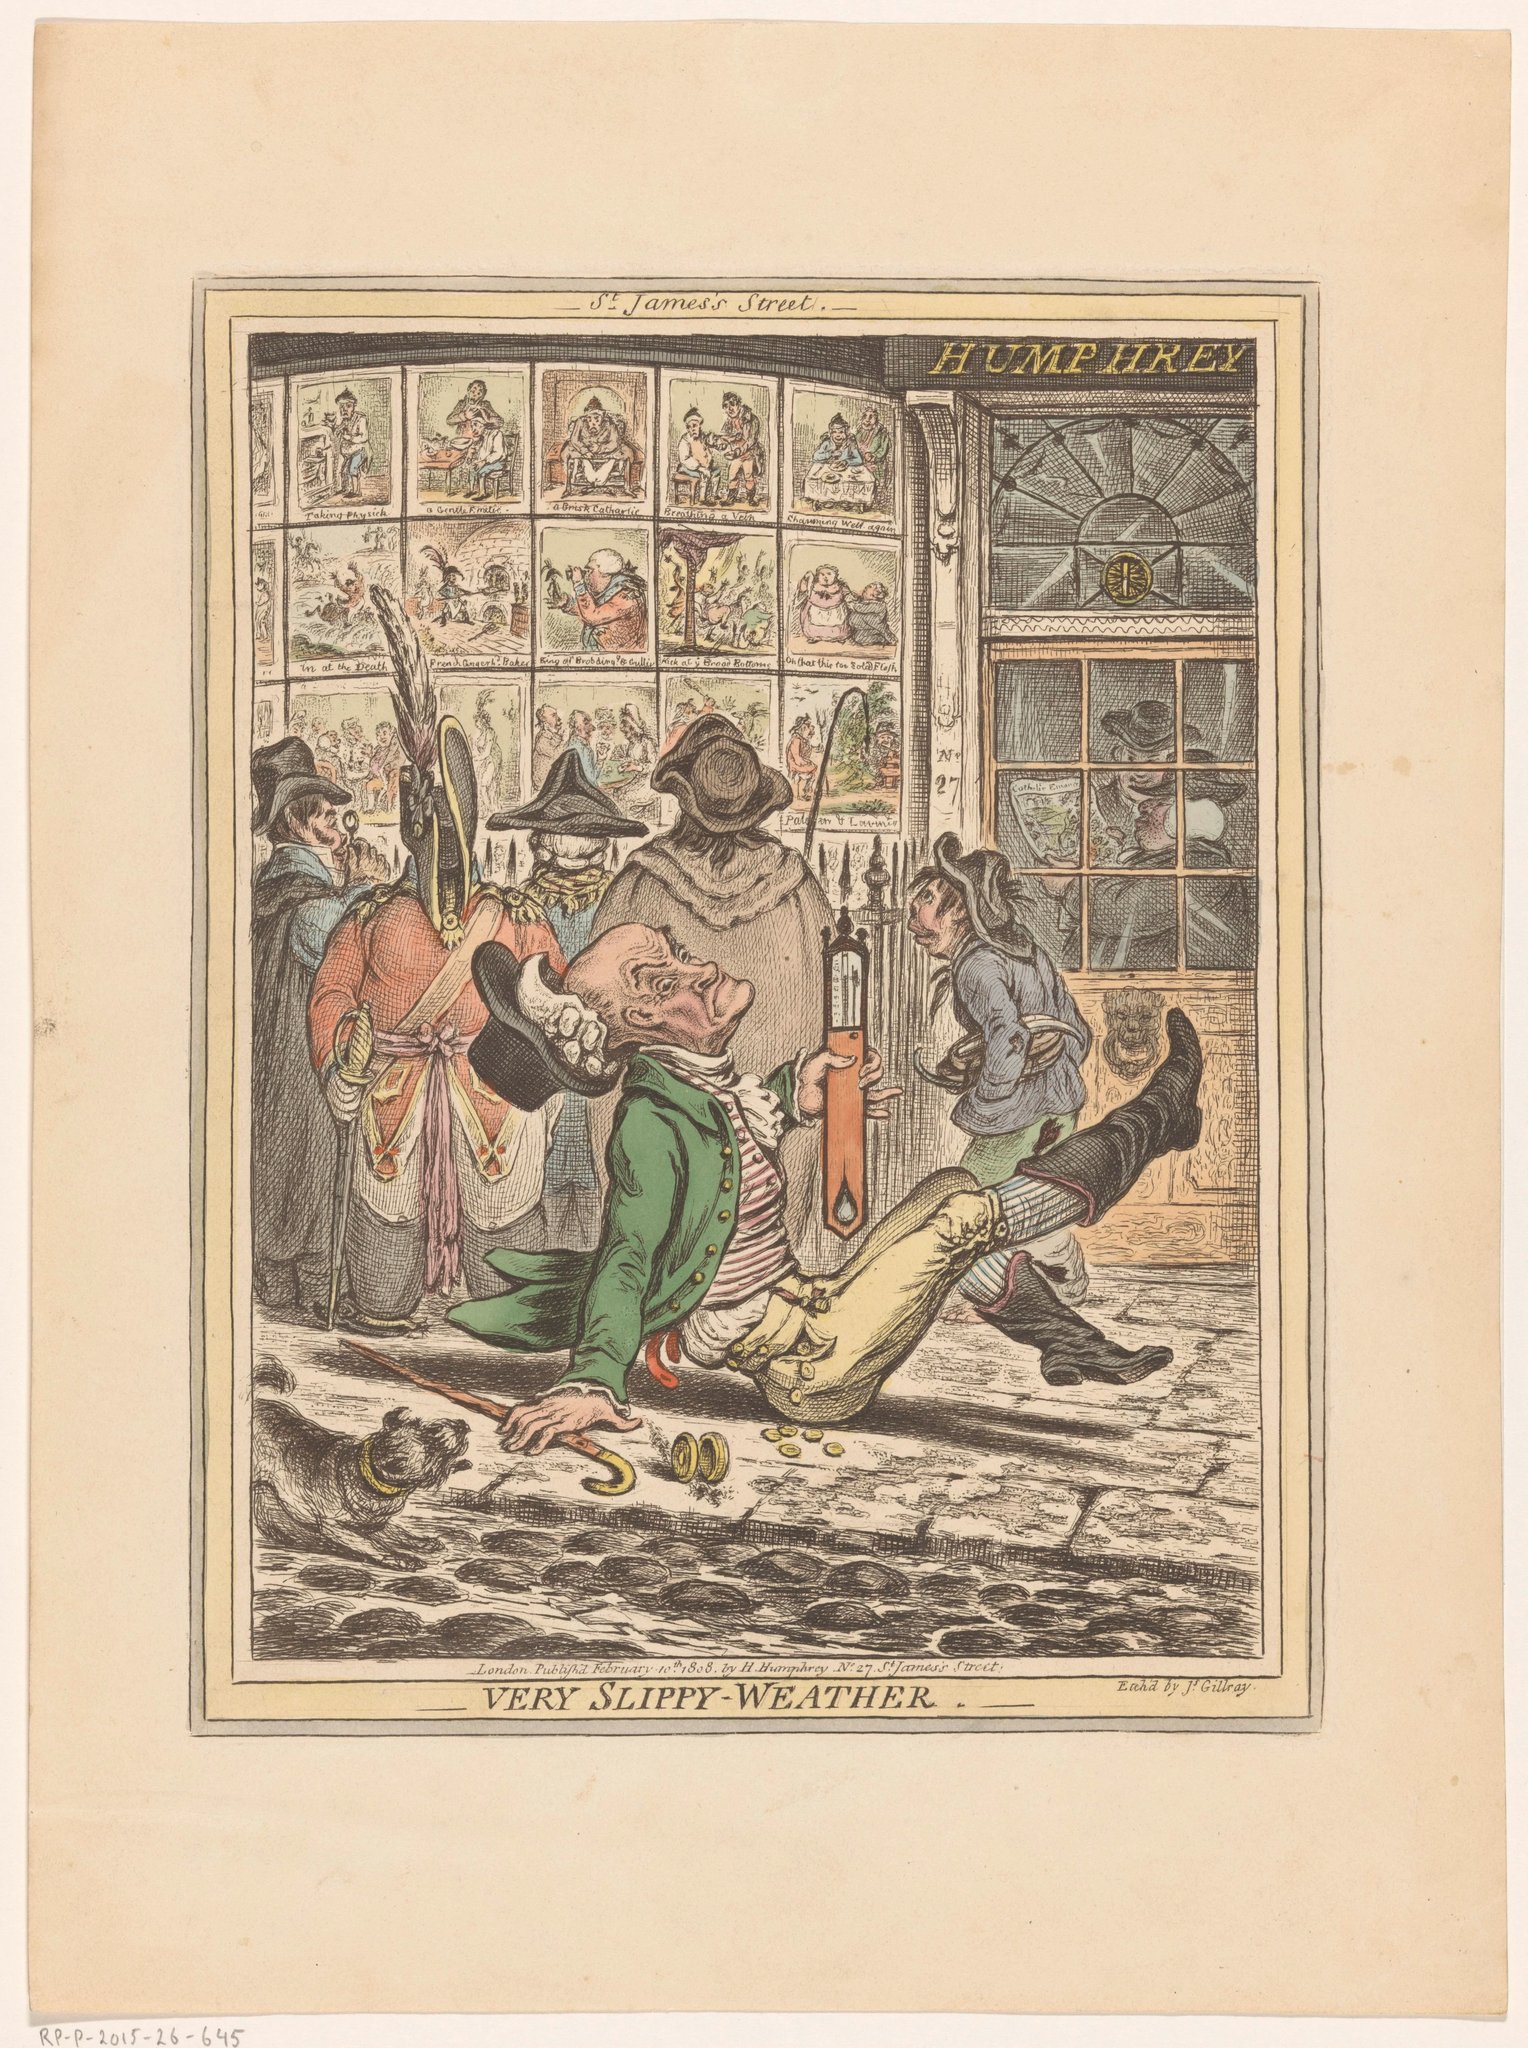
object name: print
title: Exterieur van de winkel van Hannah Humphrey te Londen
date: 1802-1808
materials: paper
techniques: etching, hand coloring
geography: london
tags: caricatures (human types), print, e.g.: engraving, etching, lithograph, publishing, publisher, barometer, shop-window, show-window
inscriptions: collector's mark: Lugt 2228, collector's mark: Lugt 4779, collector's mark: Lugt 4780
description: Exterieur van de winkel van uitgever en prentverkoper Hannah Humphrey, St James's Street 27 te Londen. Een man met een barometer in zijn linkerhand en een stok in zijn rechterhand is zojuist uitgegleden op de gladde stoep waardoor munten uit zijn zak vallen en zijn kale hoofd onder zijn hoed en pruik zichtbaar is. In de etalage hangen prenten die worden bekeken door de klanten buiten en achter de voordeur staat een man met een prent in zijn handen.